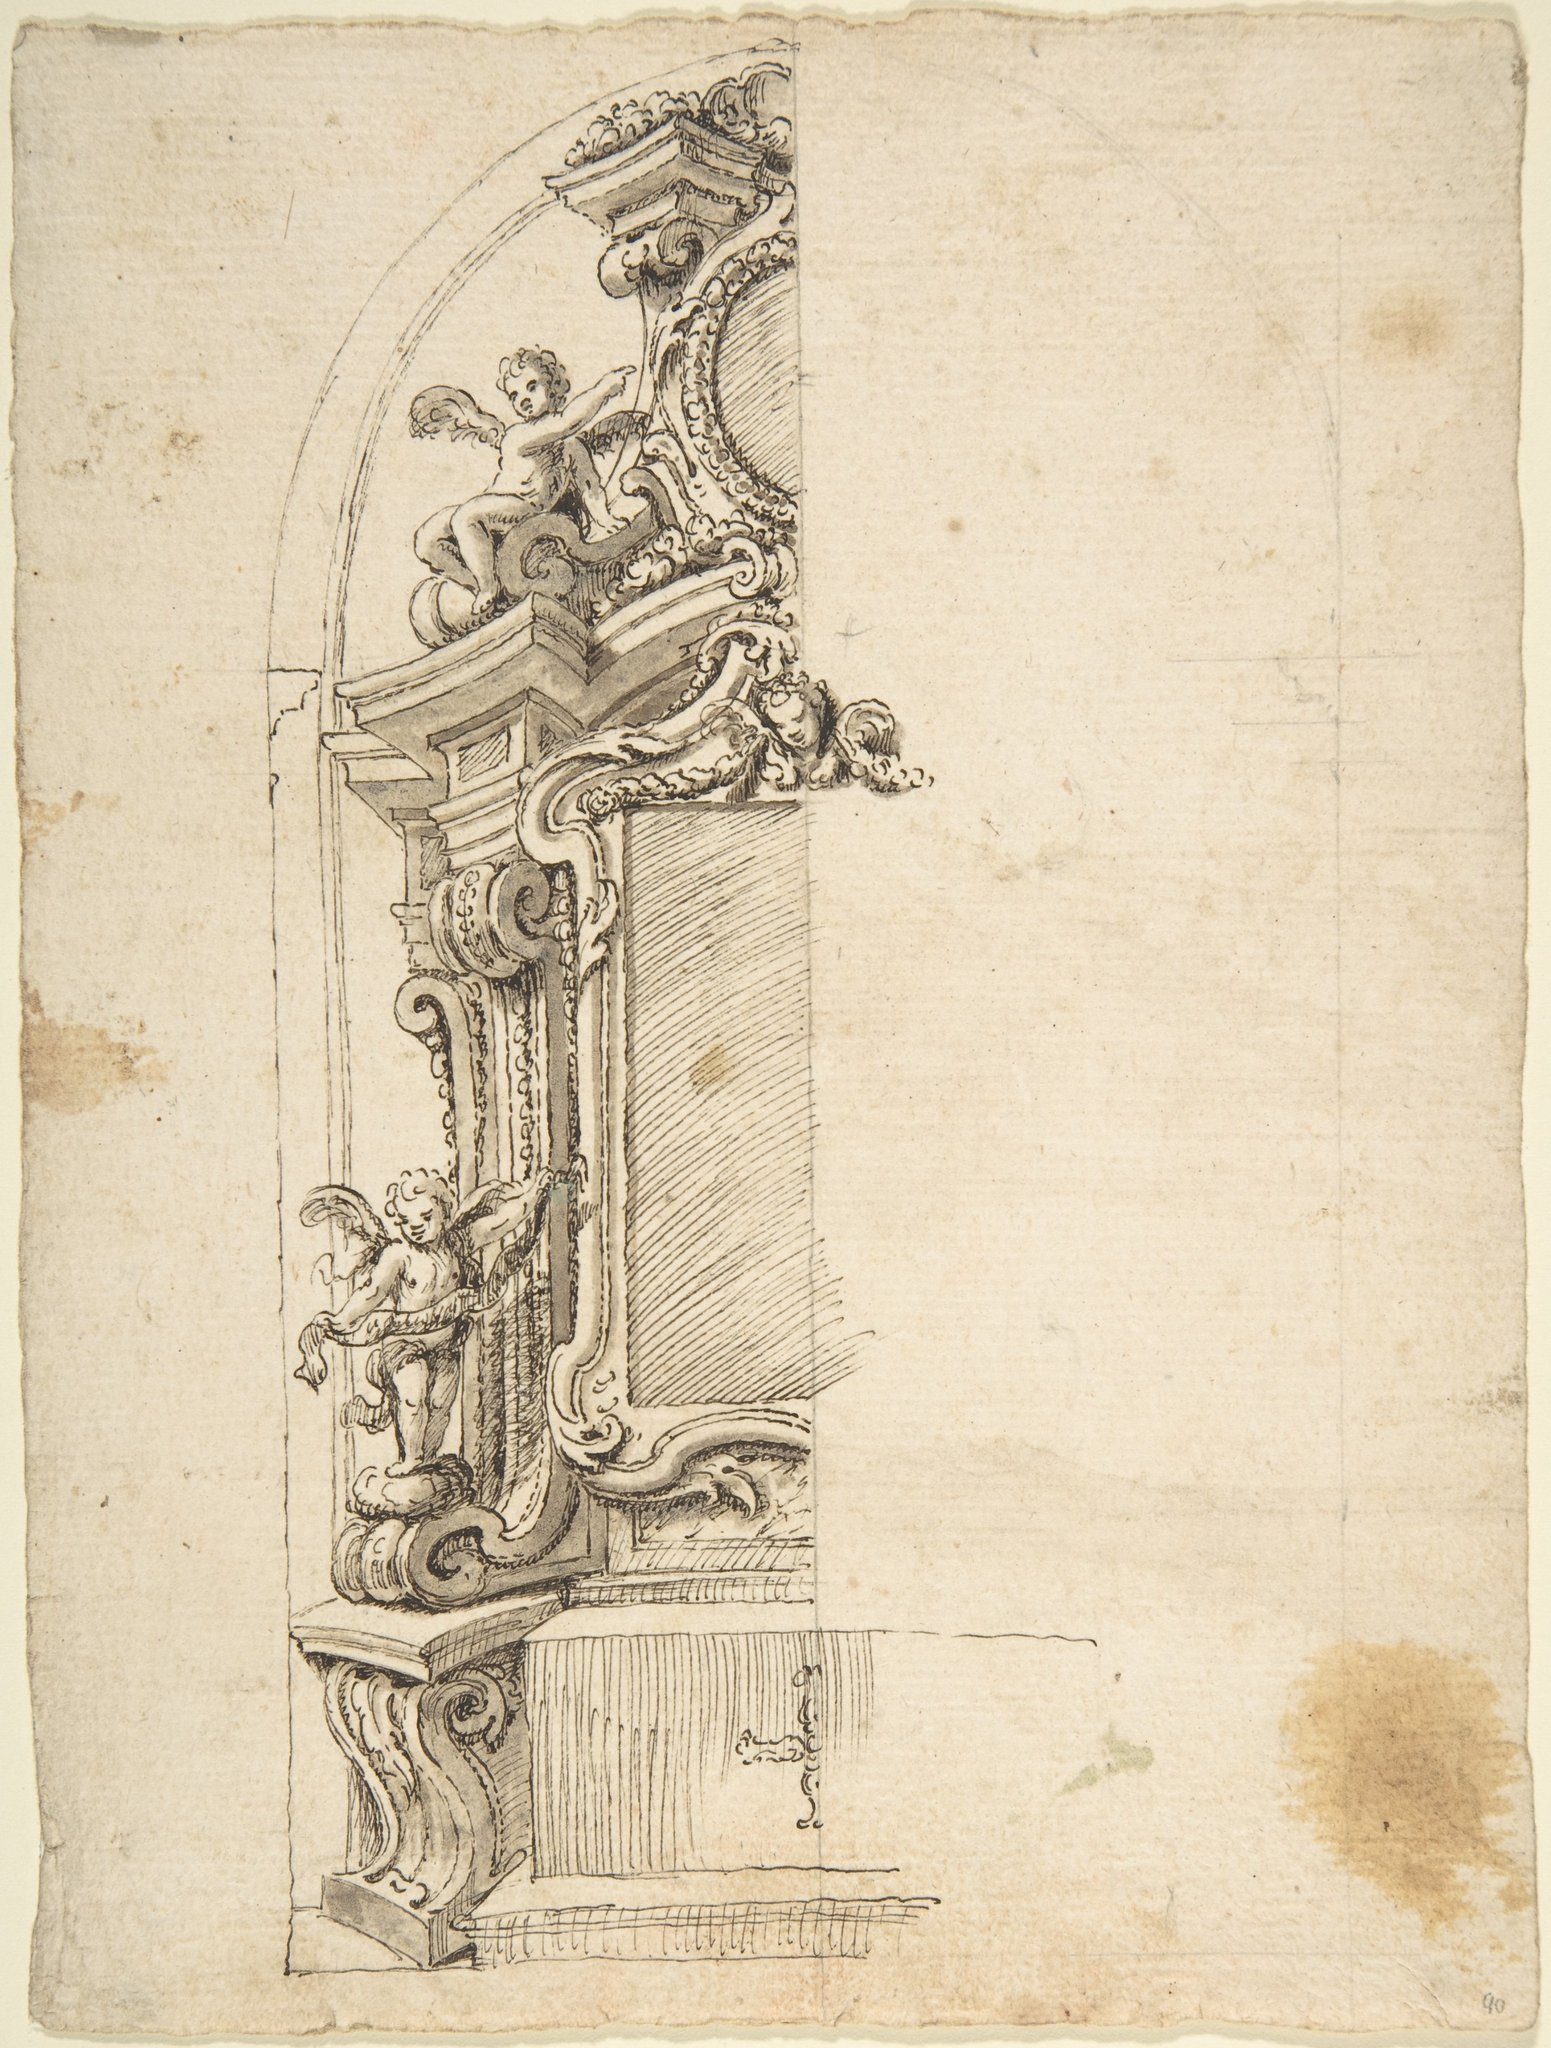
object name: drawing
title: Half design for the decoration of an Altar with Putti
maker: anonymous, italian, piedmontese, 18th century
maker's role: artist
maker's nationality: italian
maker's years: 1700-1800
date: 1700-1780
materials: graphite, ink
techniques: pen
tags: altars,putti